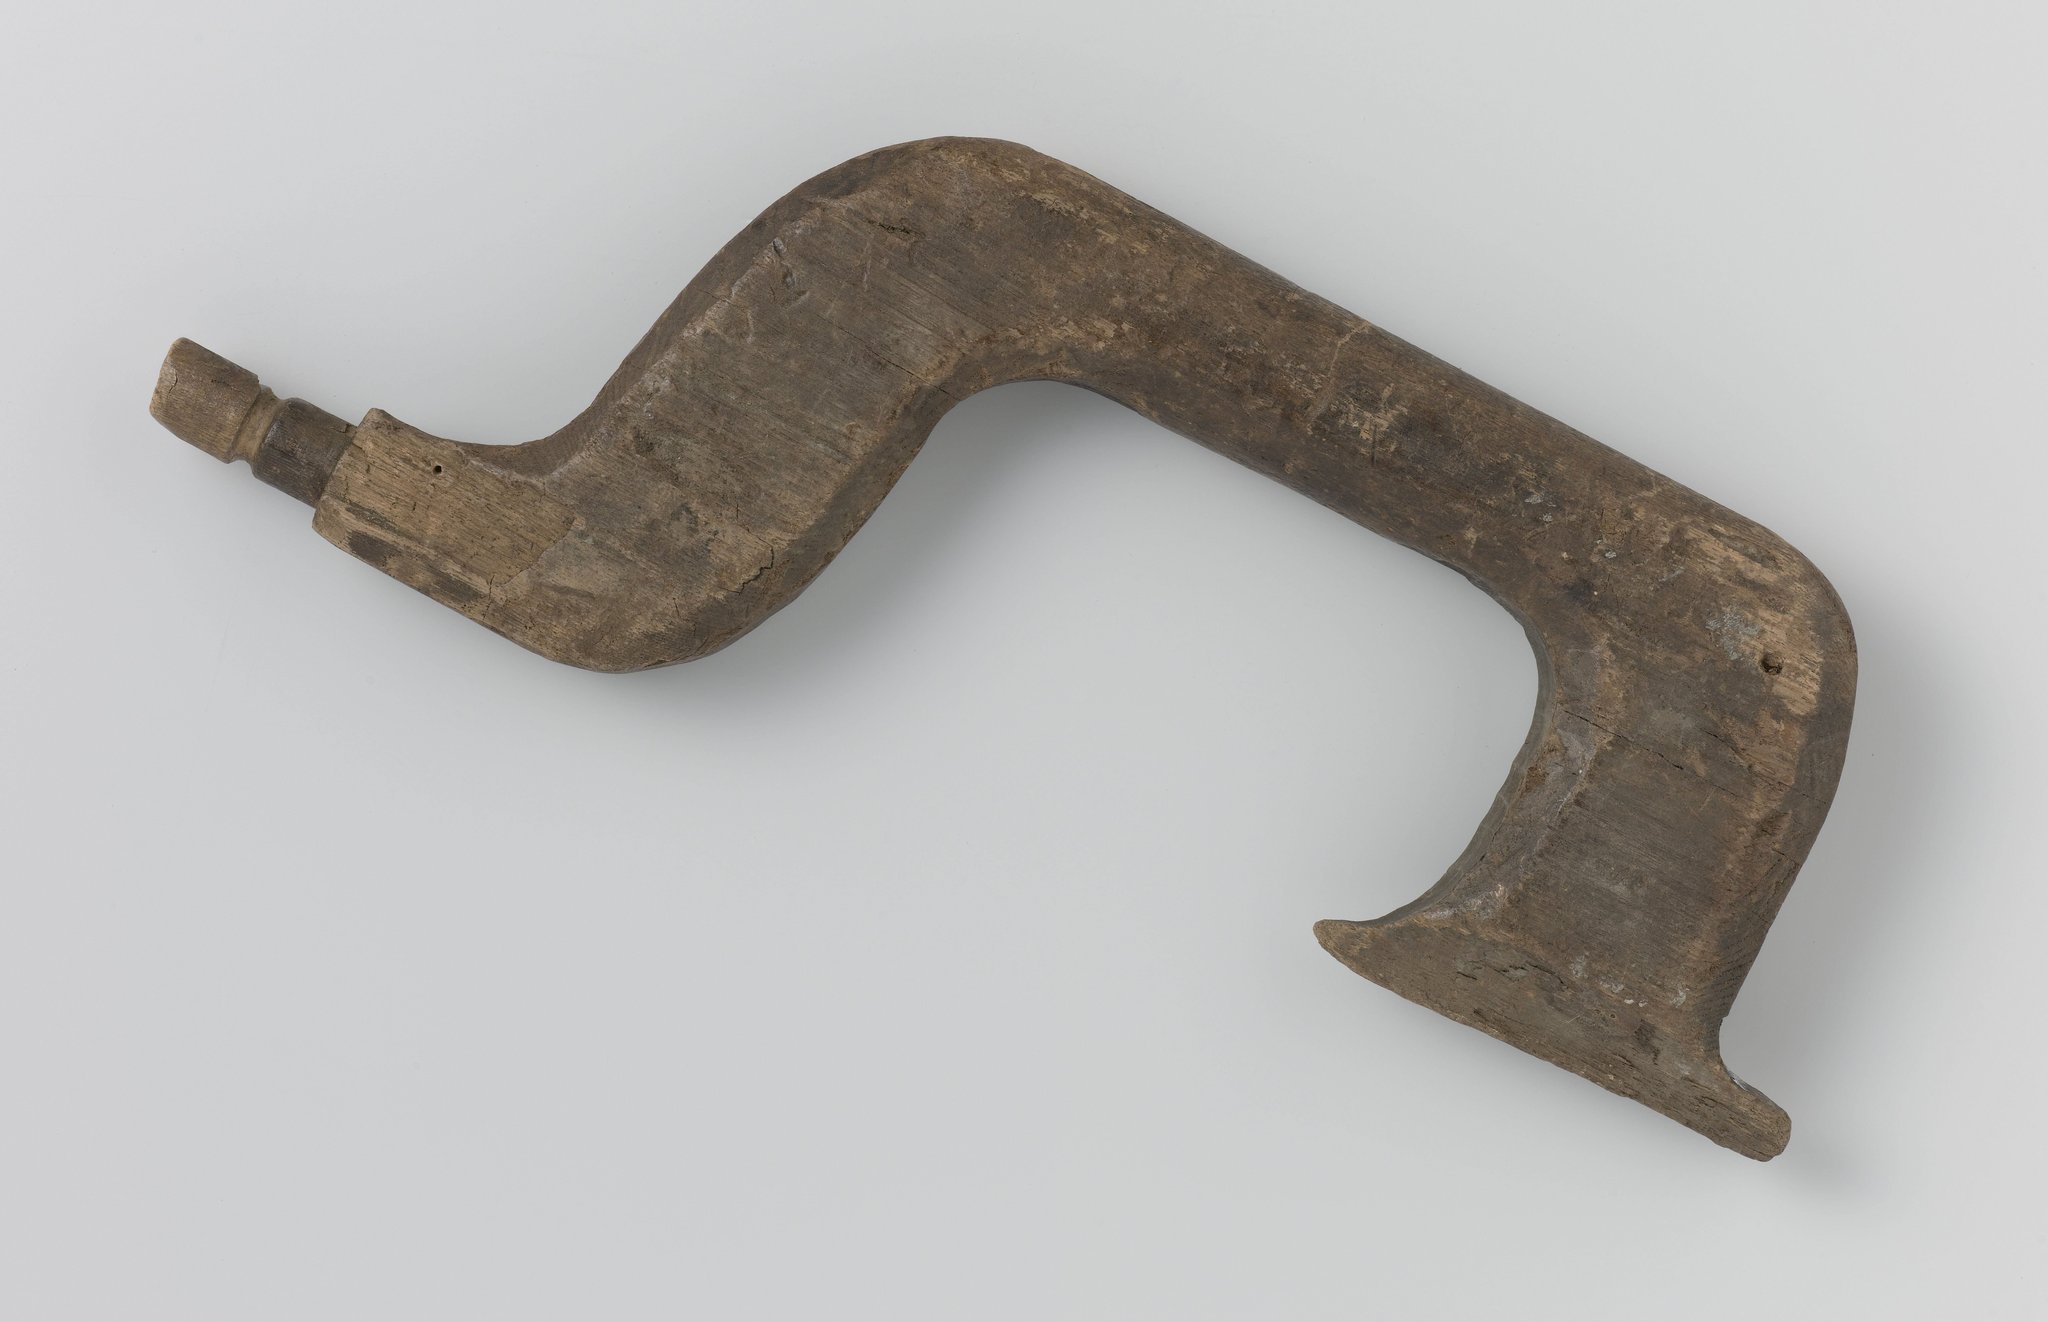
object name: drill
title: Booromslag zonder boor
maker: Anonymous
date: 1590-1596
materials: wood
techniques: cutting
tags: willem barendsz., amsterdam, jacob van heemskerck